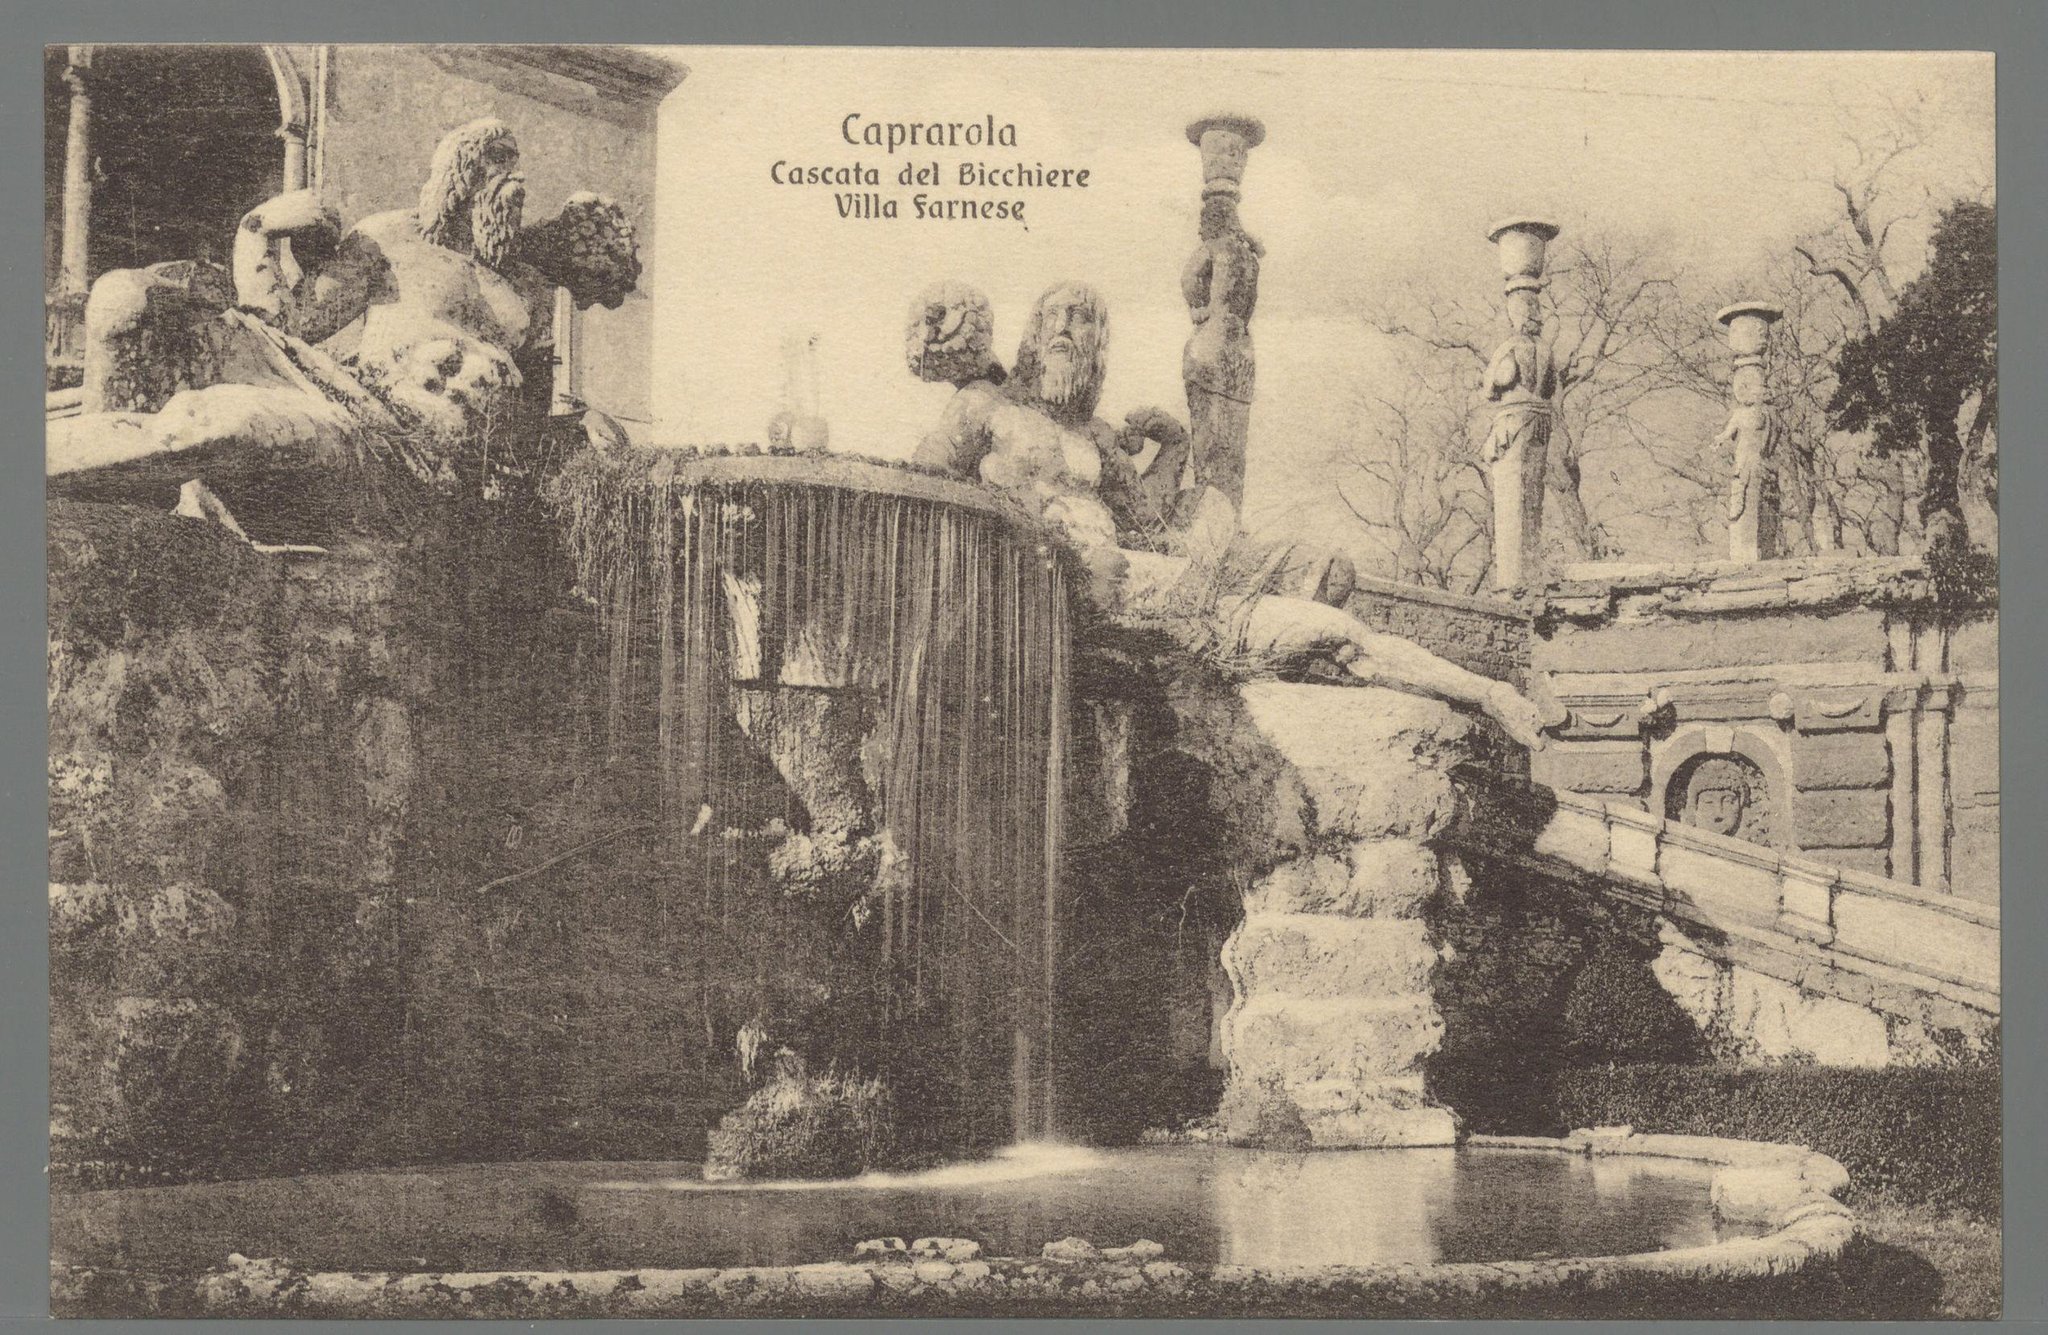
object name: photomechanical print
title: Caprarola. Cascata del Bicchiere. Villa Farnese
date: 1906-1930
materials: cardboard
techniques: photograph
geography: caprarola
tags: statues, sculptures in garden, garden cascade